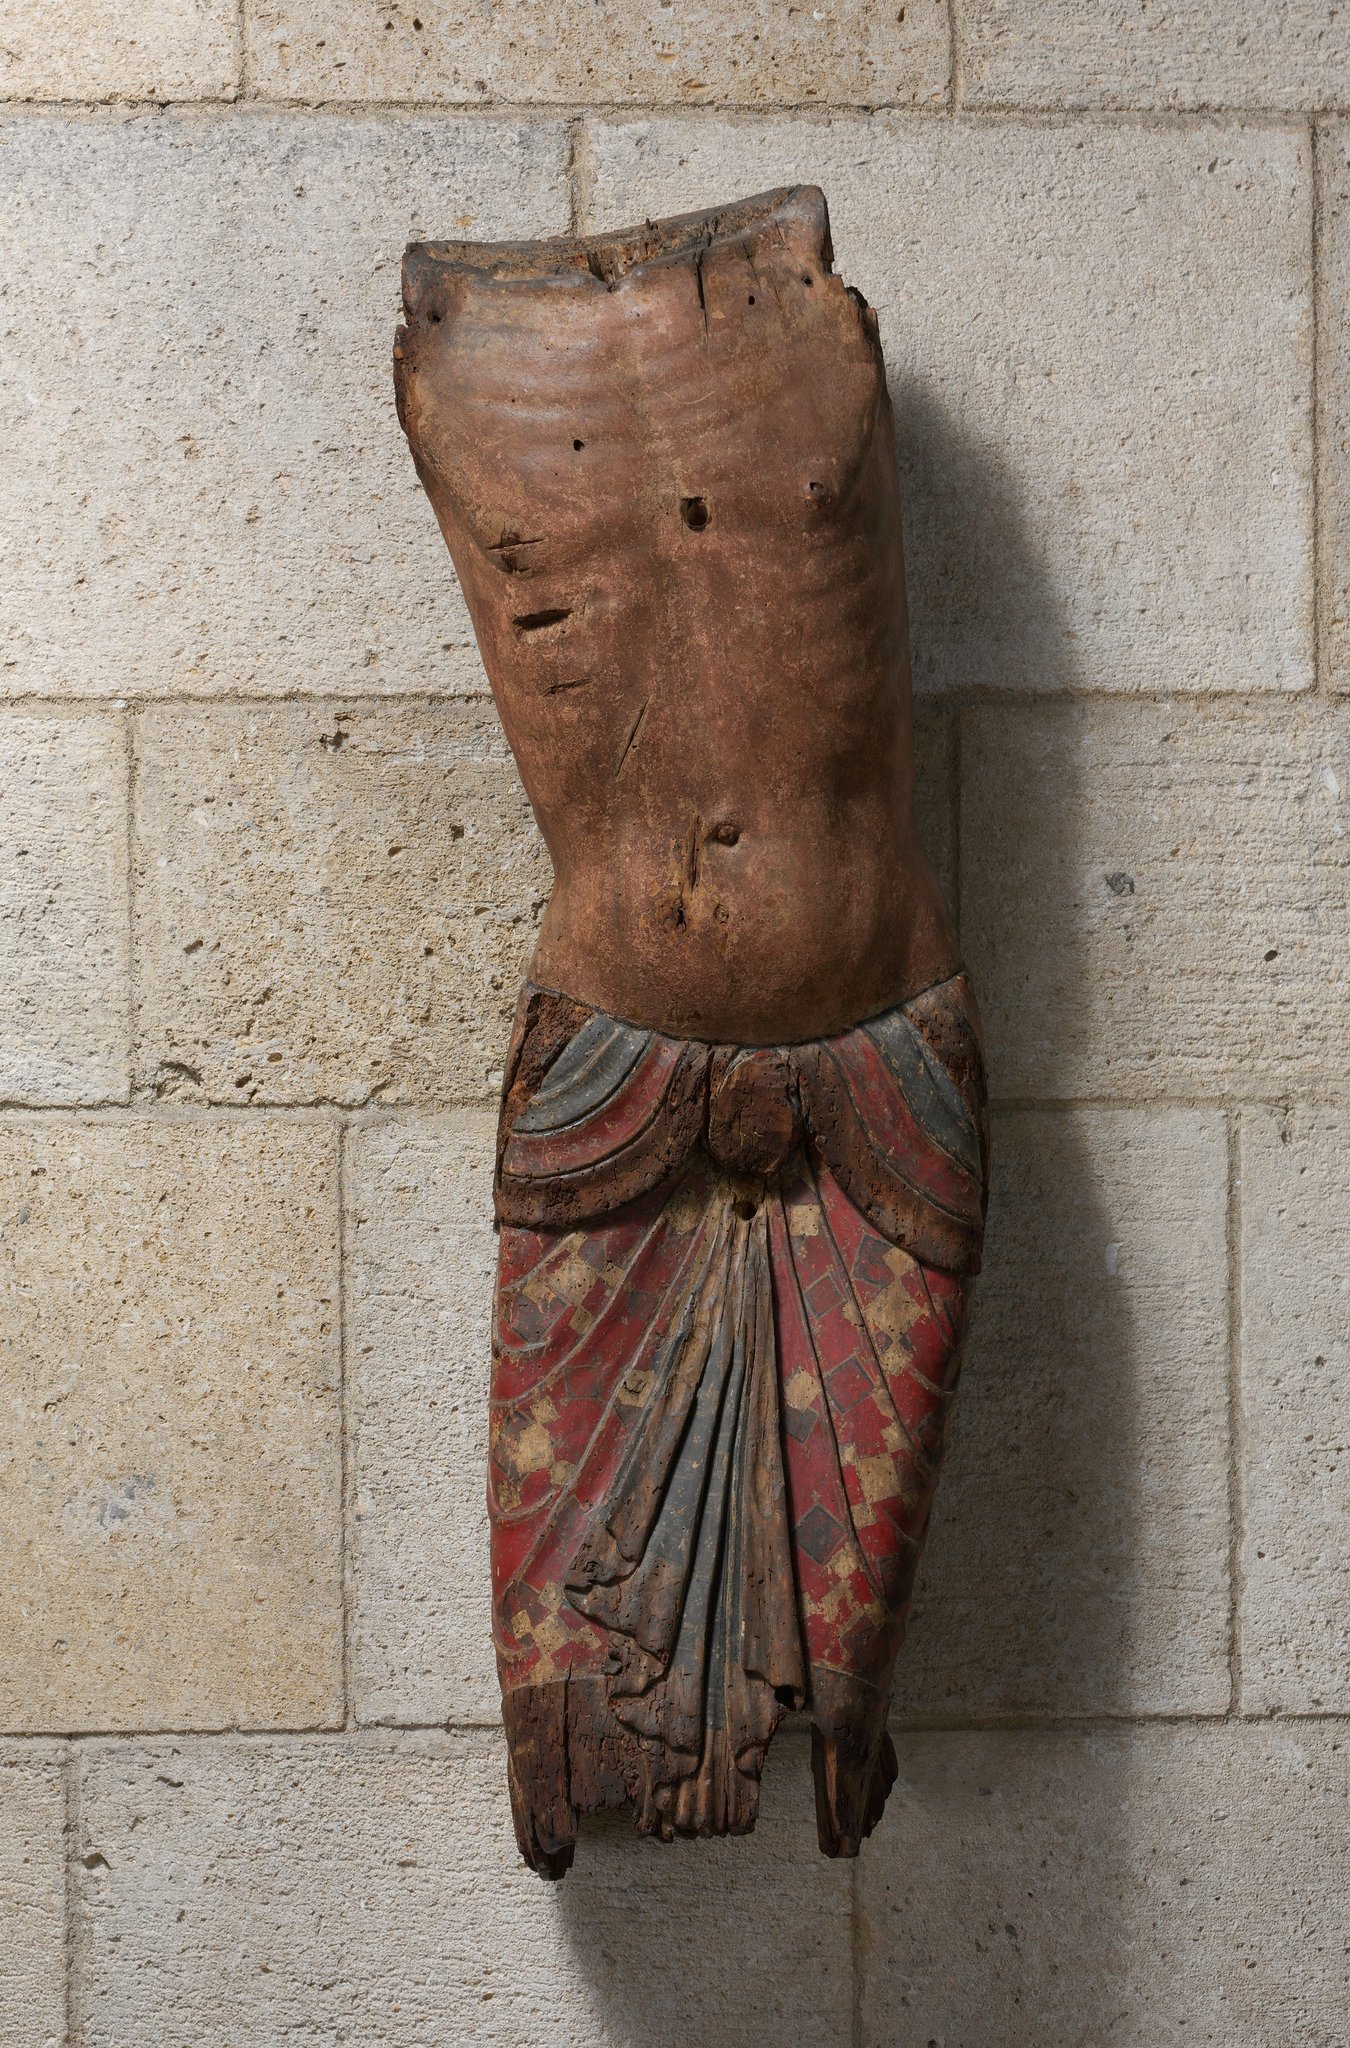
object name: sculpture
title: Torso of Christ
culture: french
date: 1167-1200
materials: gesso, metal leaf, paint, wood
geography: france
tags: christ